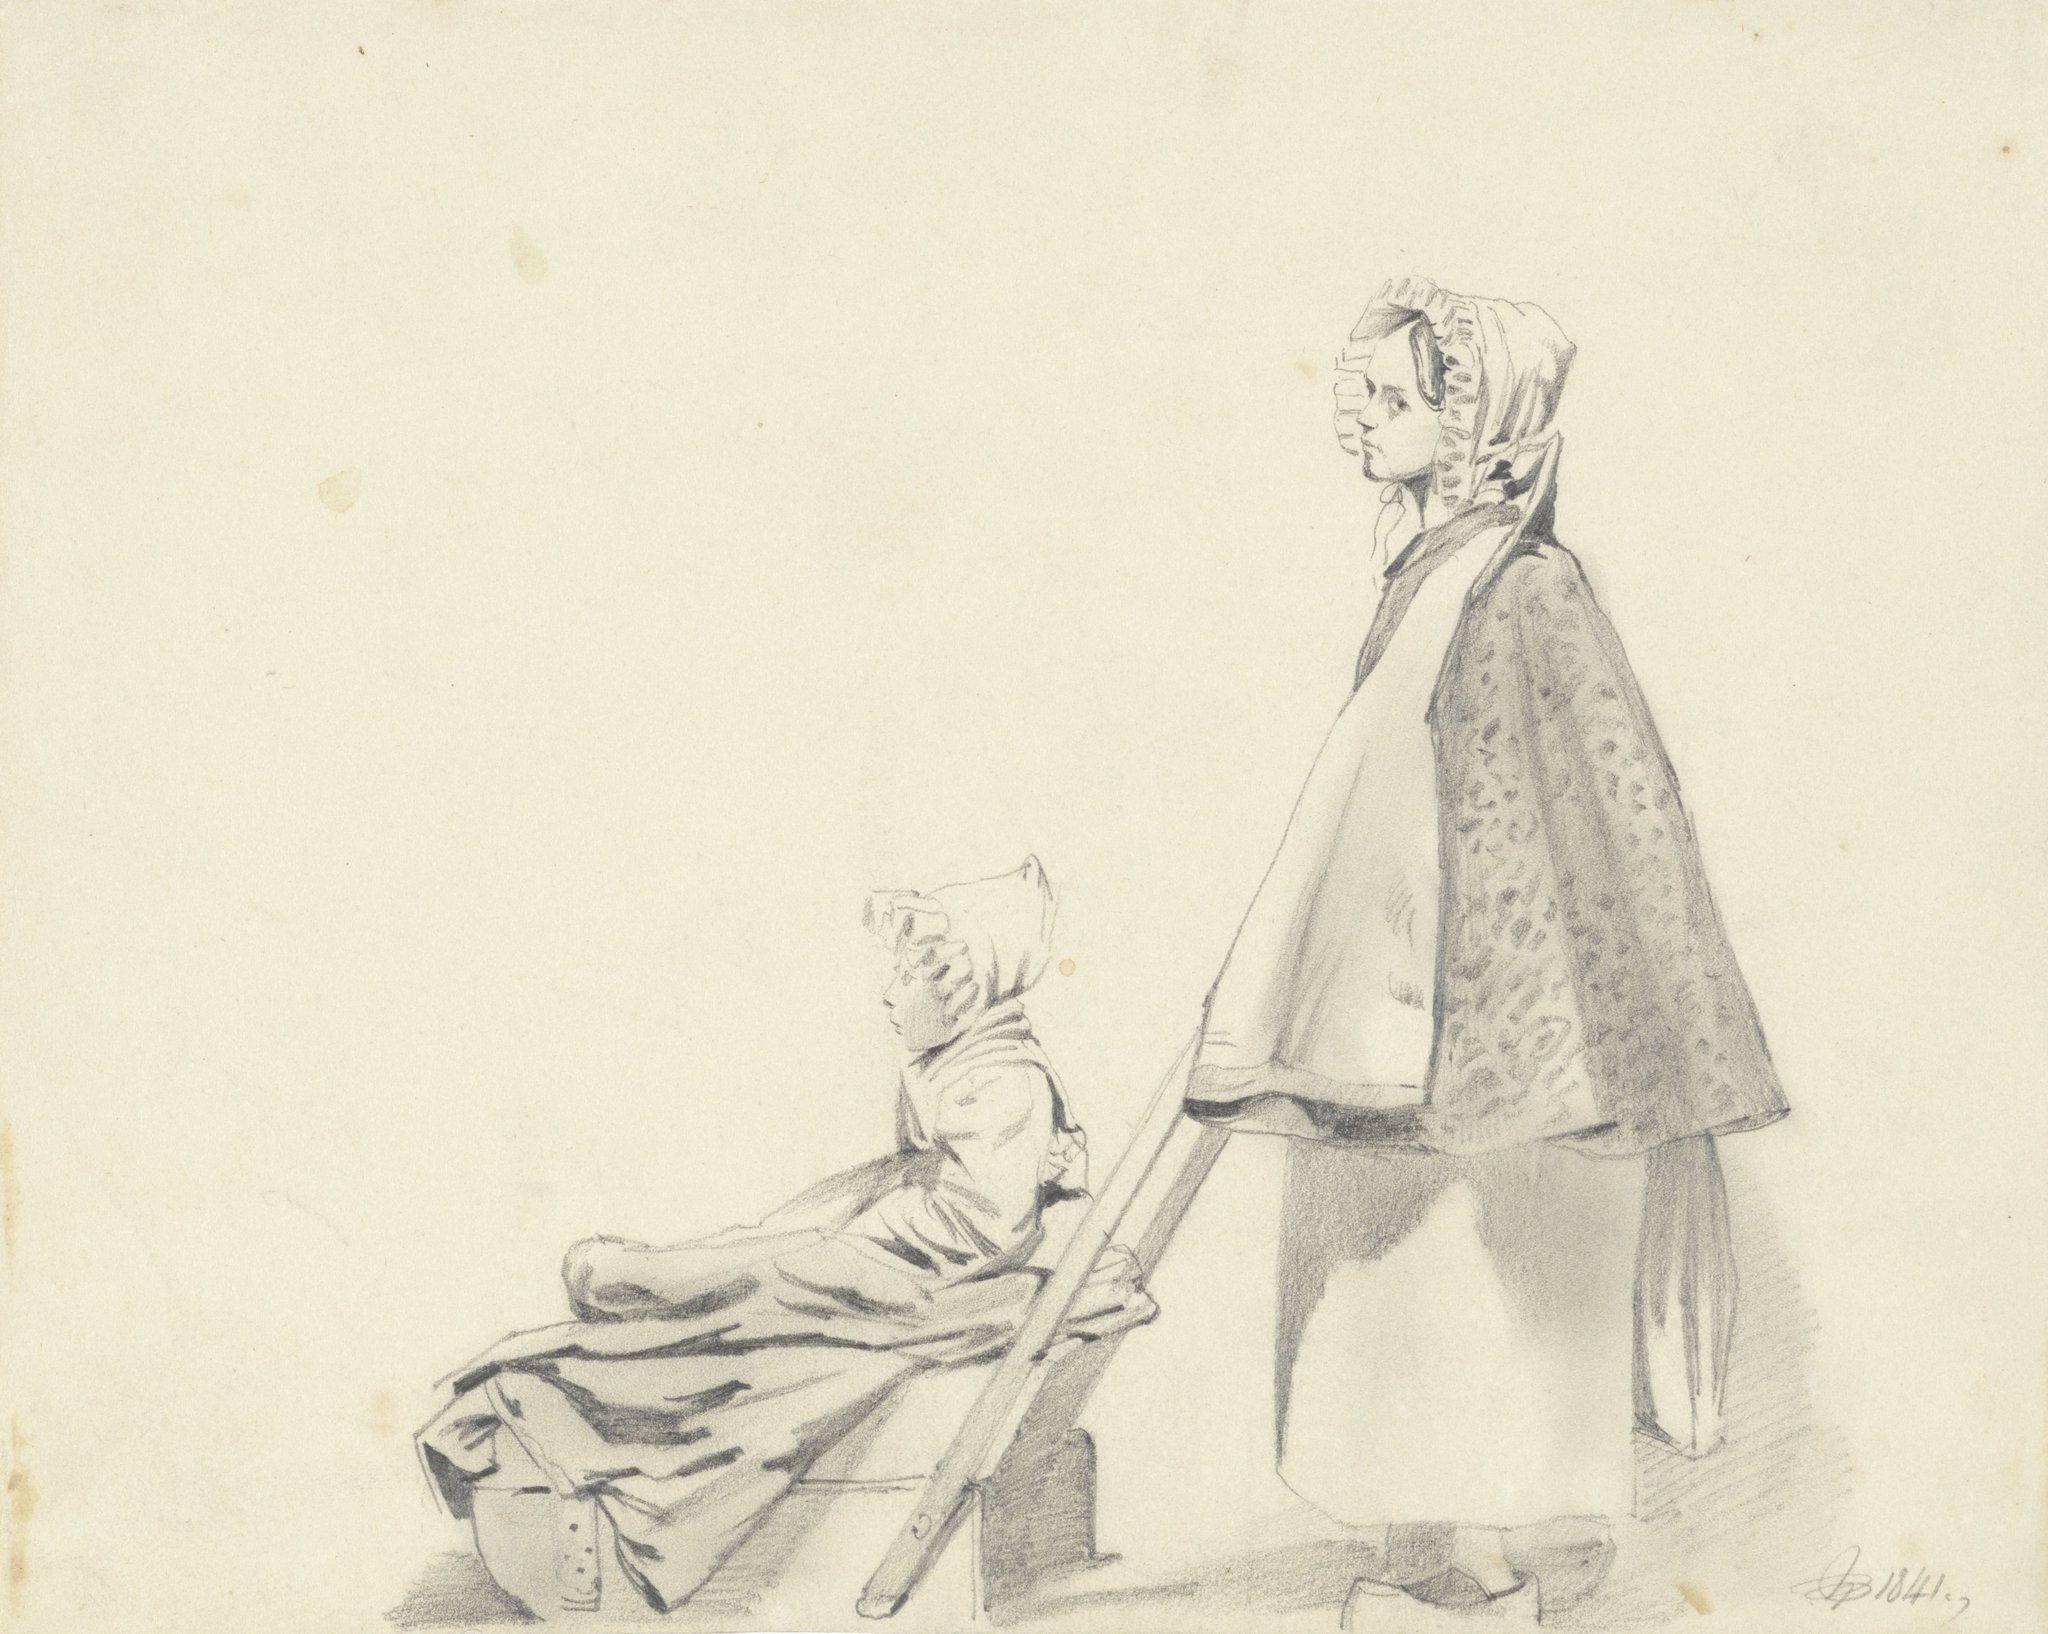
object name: drawing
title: Vrouw met kind in kinderwagen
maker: pieter van loon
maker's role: draughtsman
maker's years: 1801-1873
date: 1841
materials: paper, pencil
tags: baby-carriage, pram, perambulator